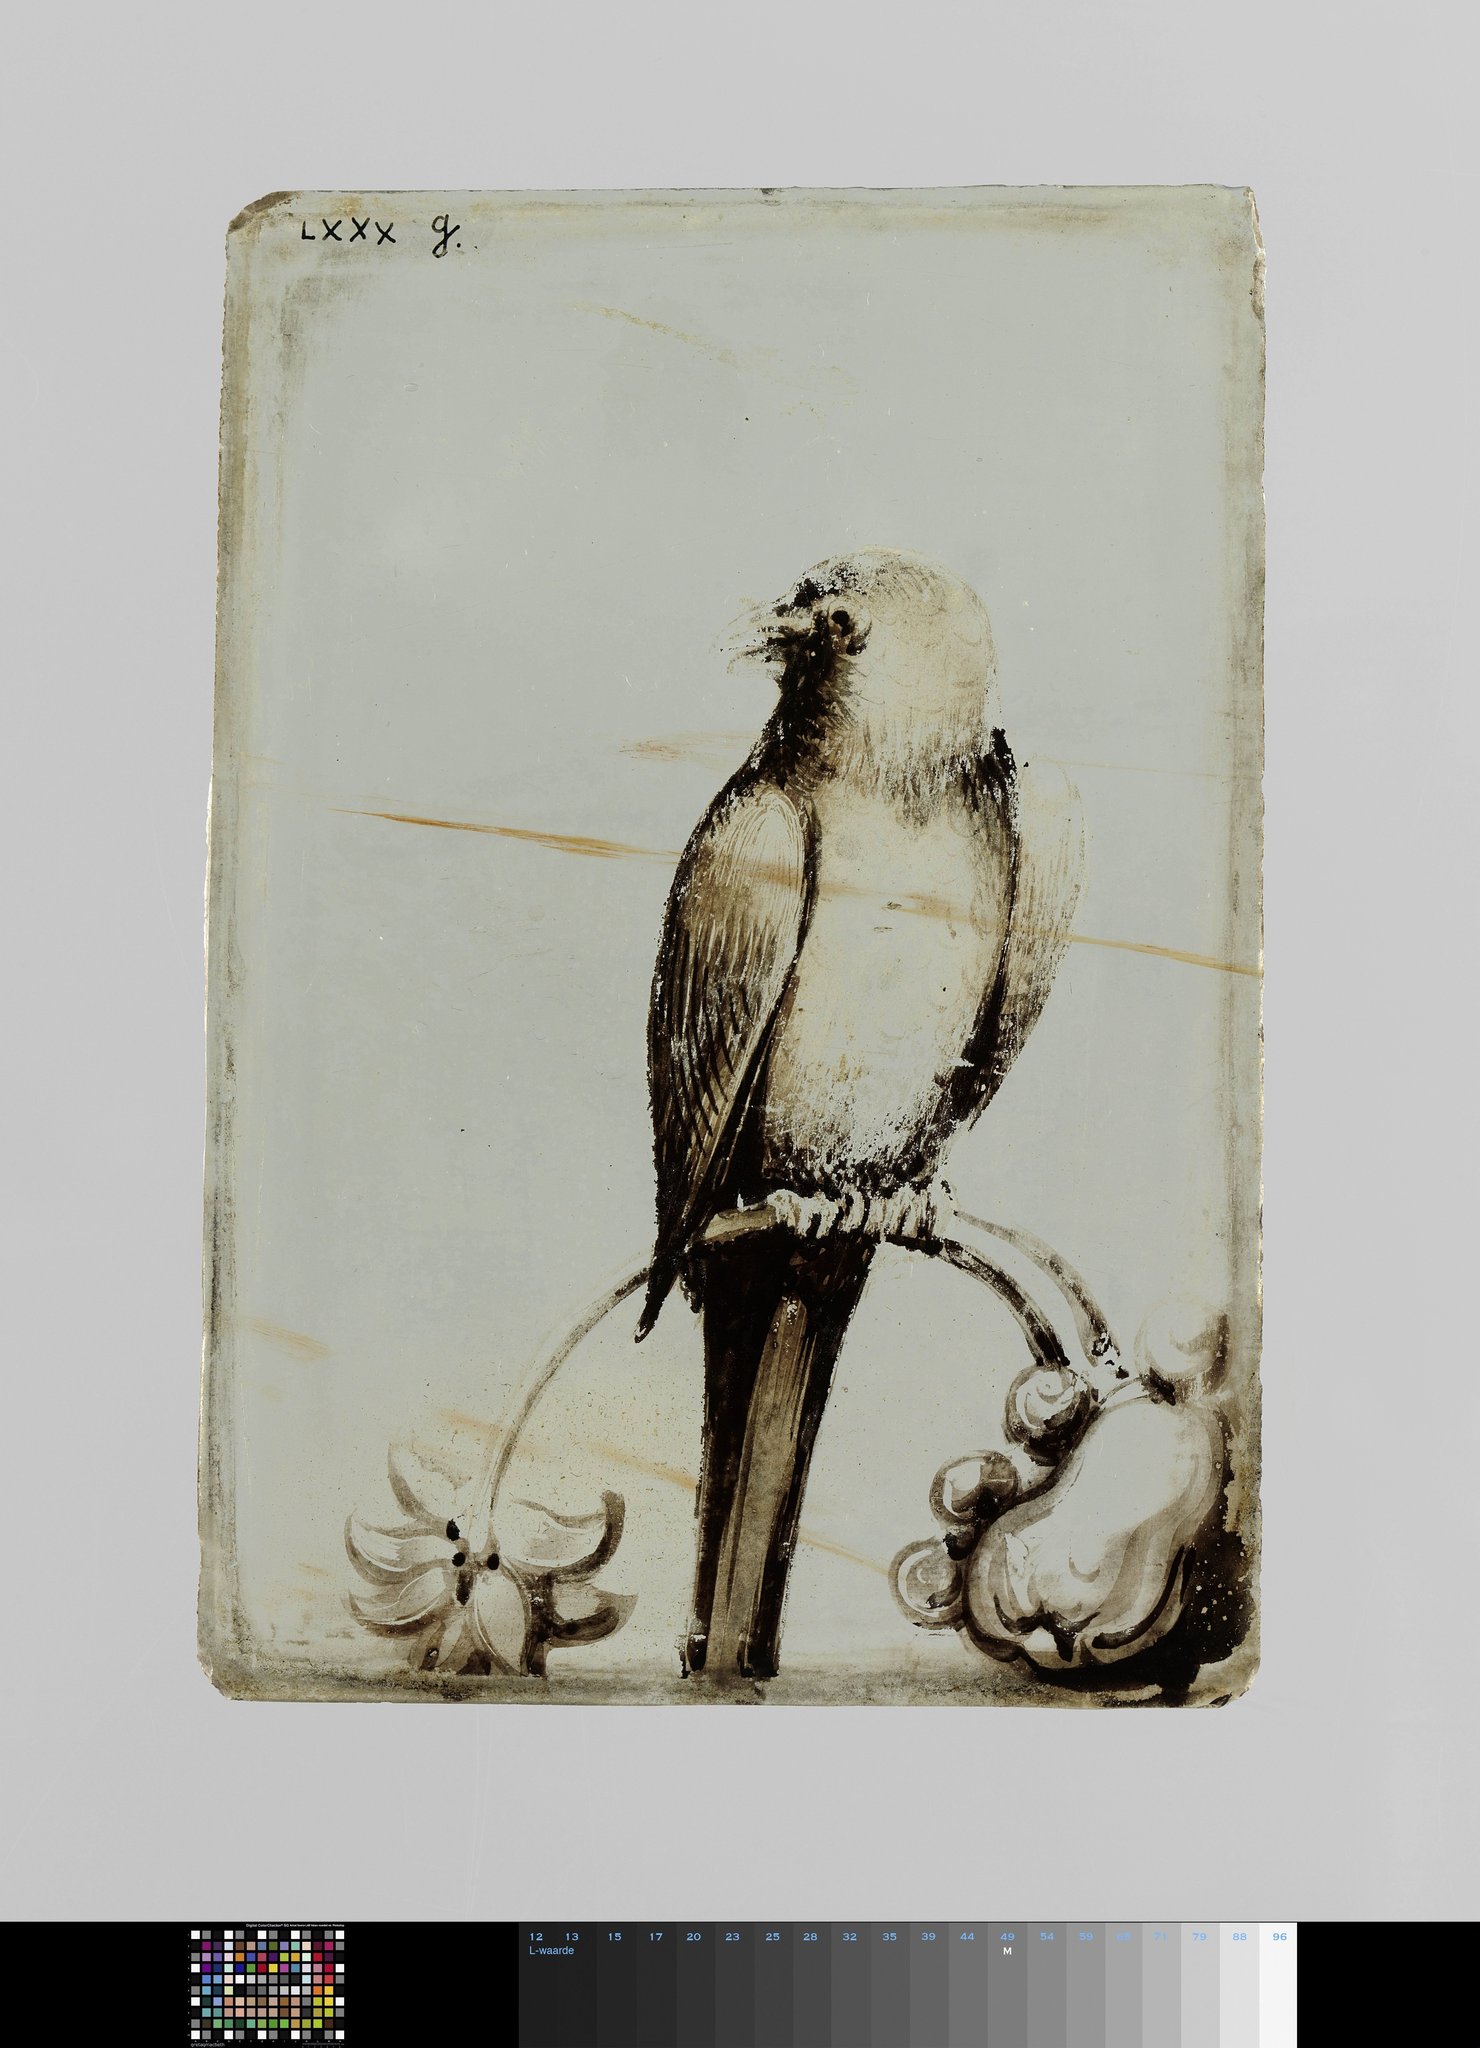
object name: light window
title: Ruit met een vogel op een kromgebogen tak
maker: Anonymous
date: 1650-1675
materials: glass, lead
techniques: enamel painting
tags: birds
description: Een gebrandschilderde ruit met de afbeelding van een vogel op een kromgebogen tak in grisaille. Deze ruit is spiegelbeeldig aan LXXX-I.